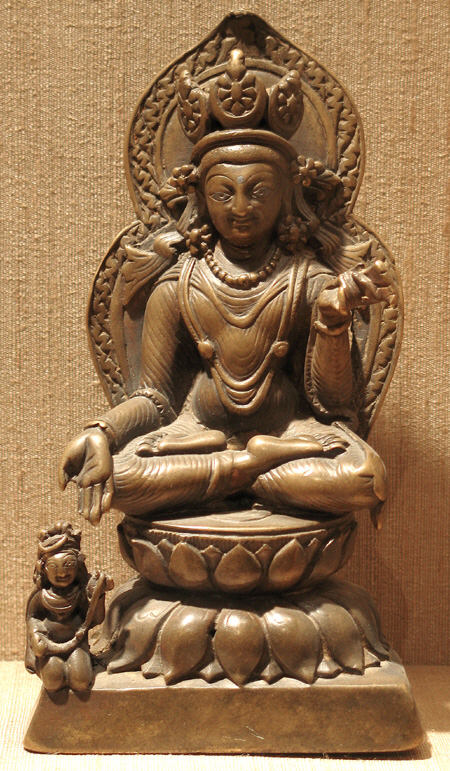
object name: sculpture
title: Crowned and Jeweled Buddha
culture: kashmiri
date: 801-900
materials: copper, silver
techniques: inlay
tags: kashmir,buddhism,buddha